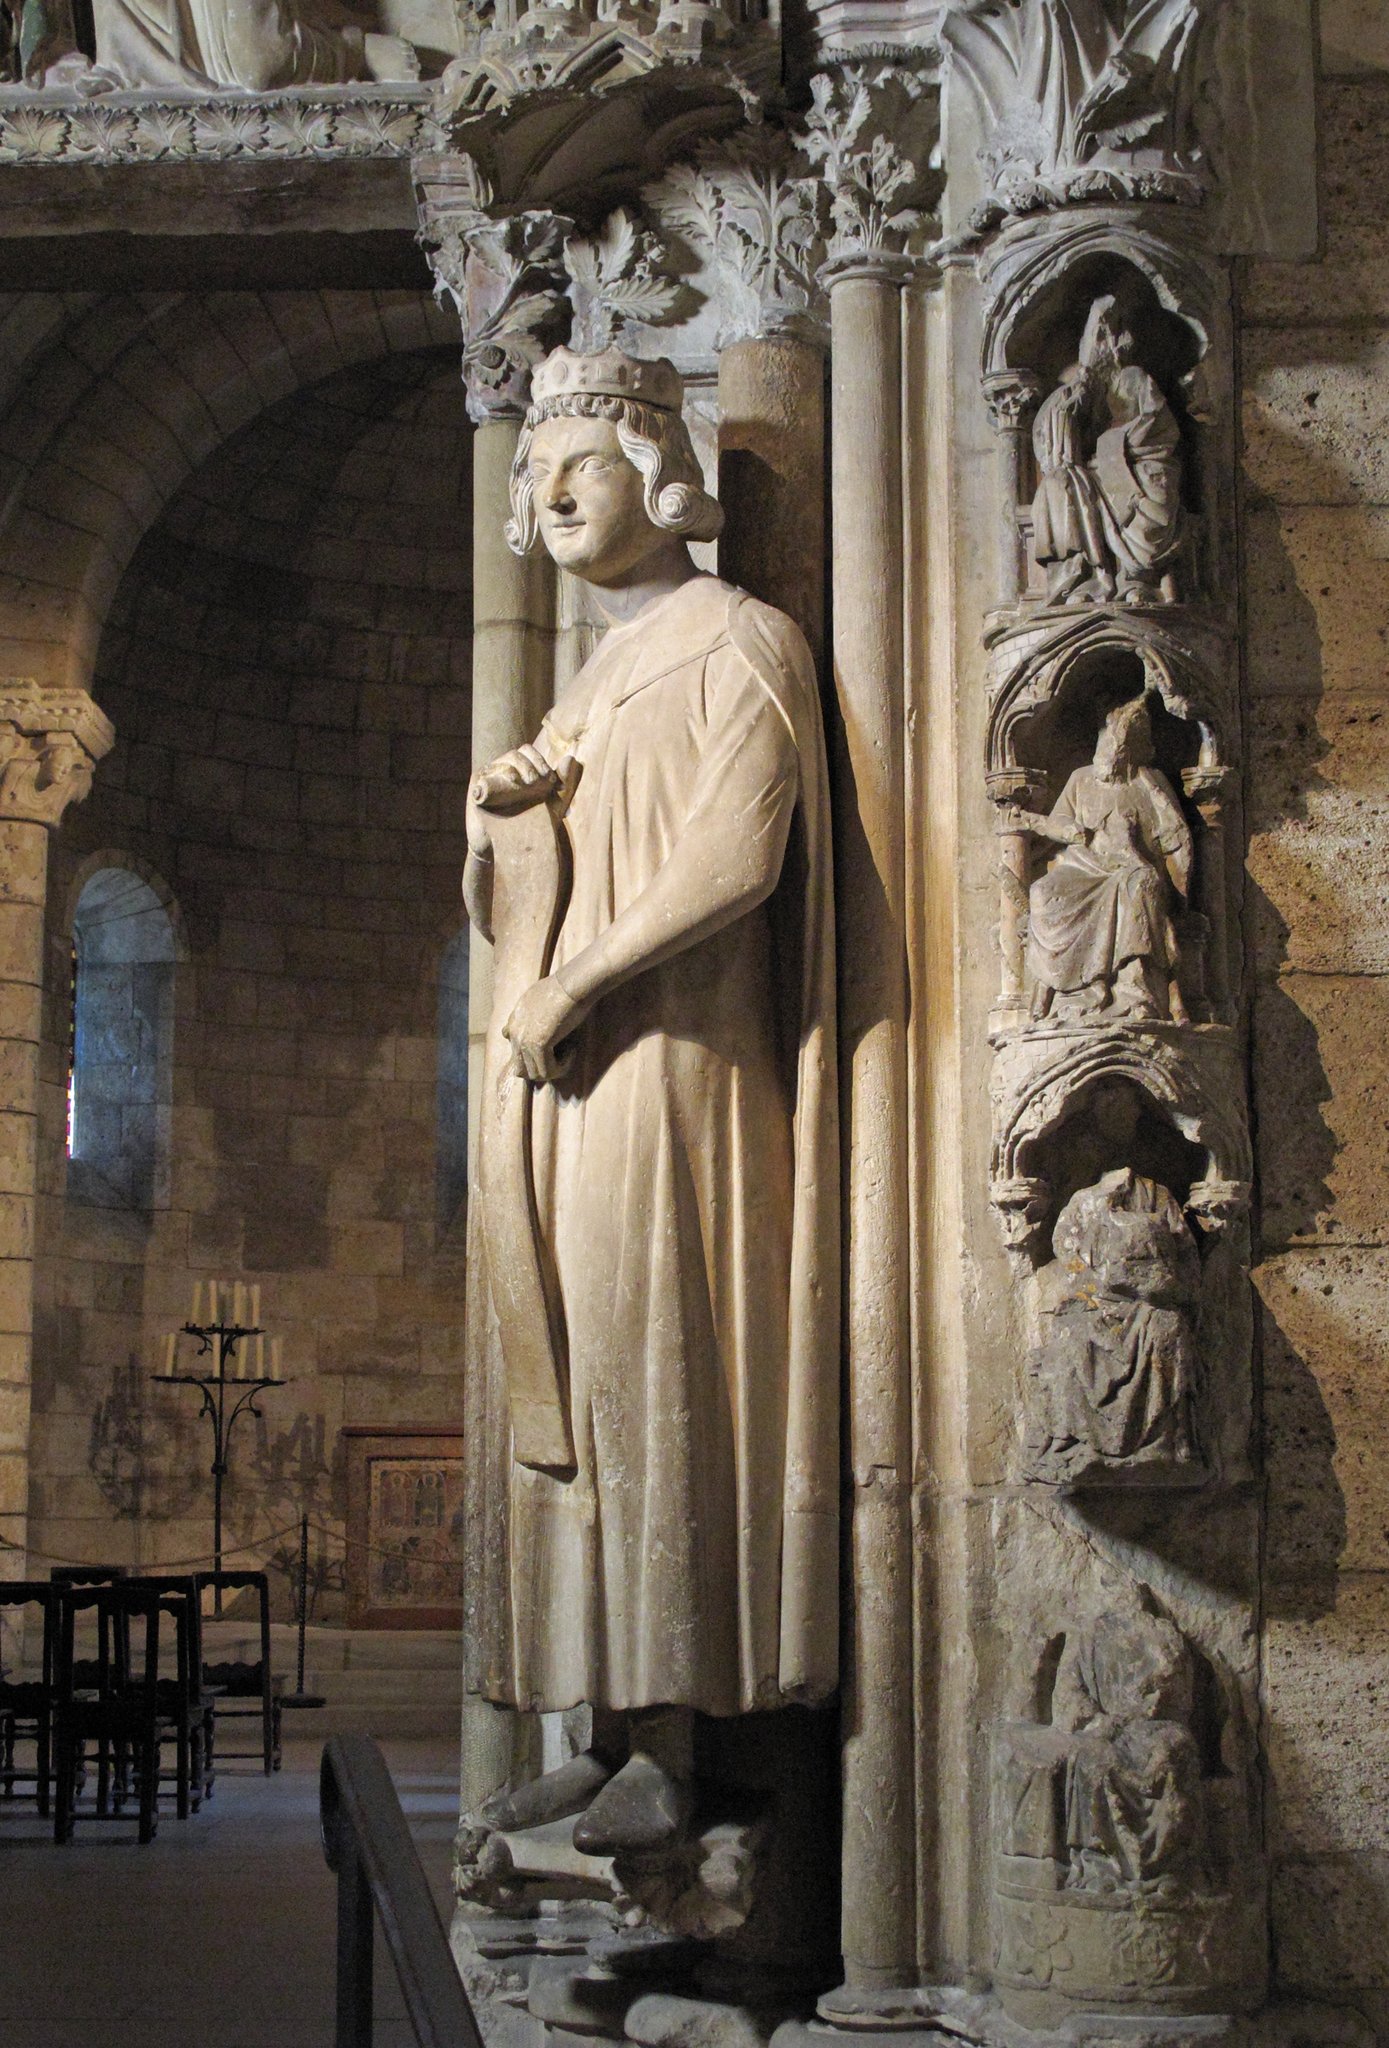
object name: statue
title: King Clothar I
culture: french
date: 1250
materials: limestone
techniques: polychrome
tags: doorways,kings,men